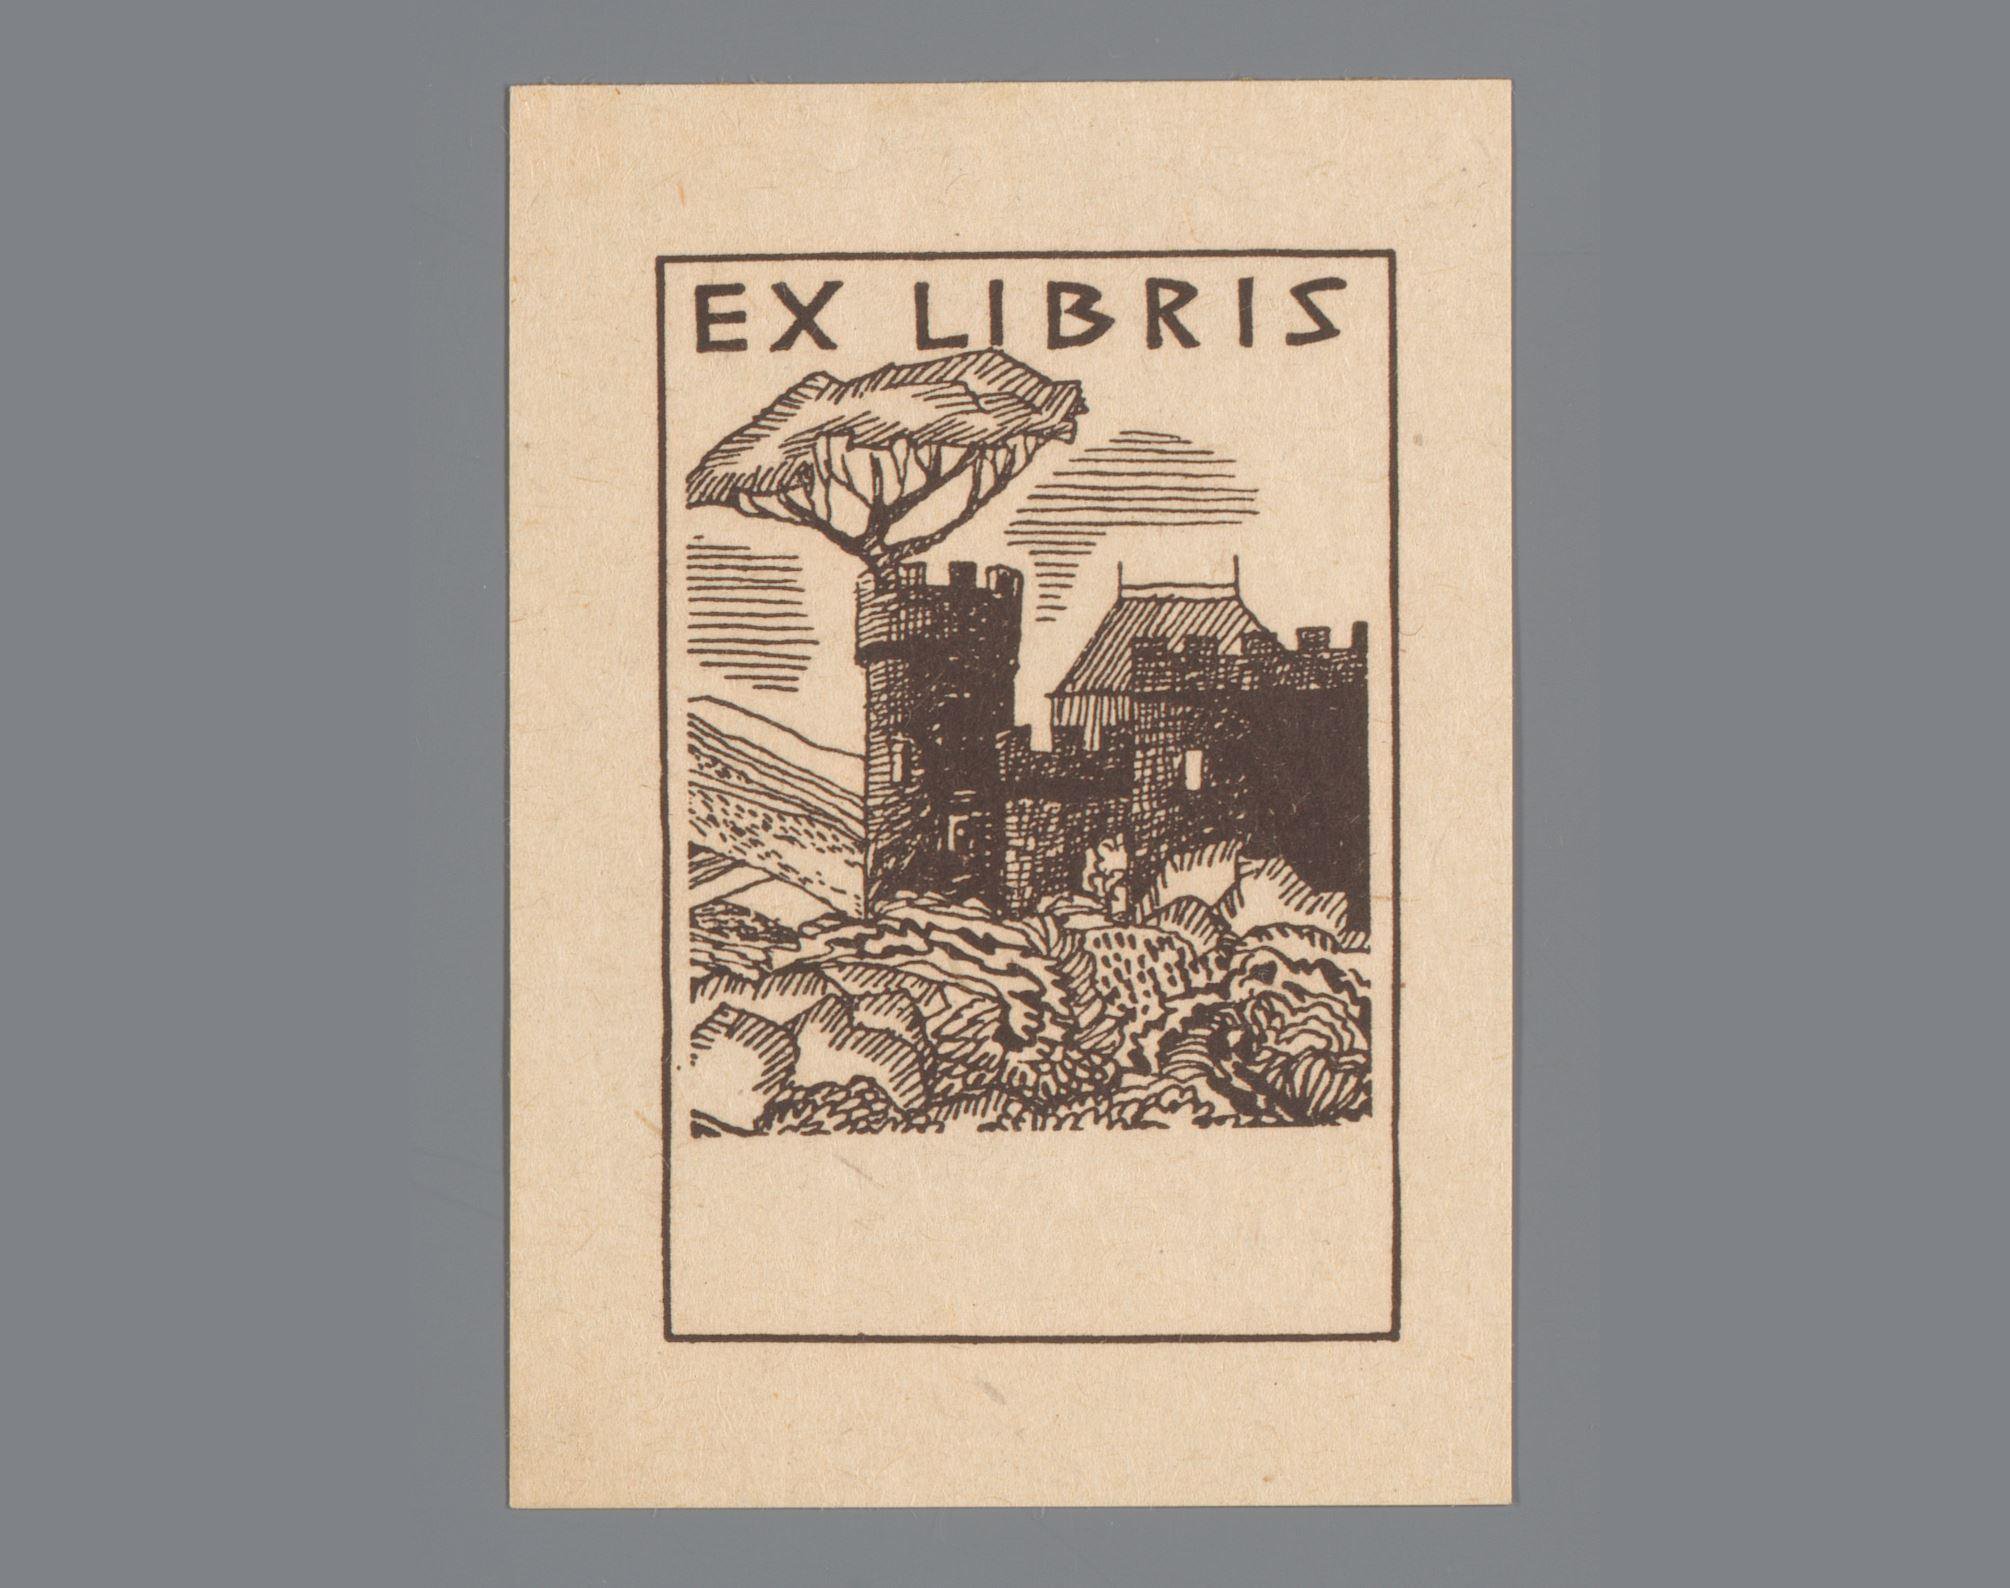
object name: bookplate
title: Ex libris van onbekend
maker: Anonymous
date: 1900-1999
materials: paper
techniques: printing block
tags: castle